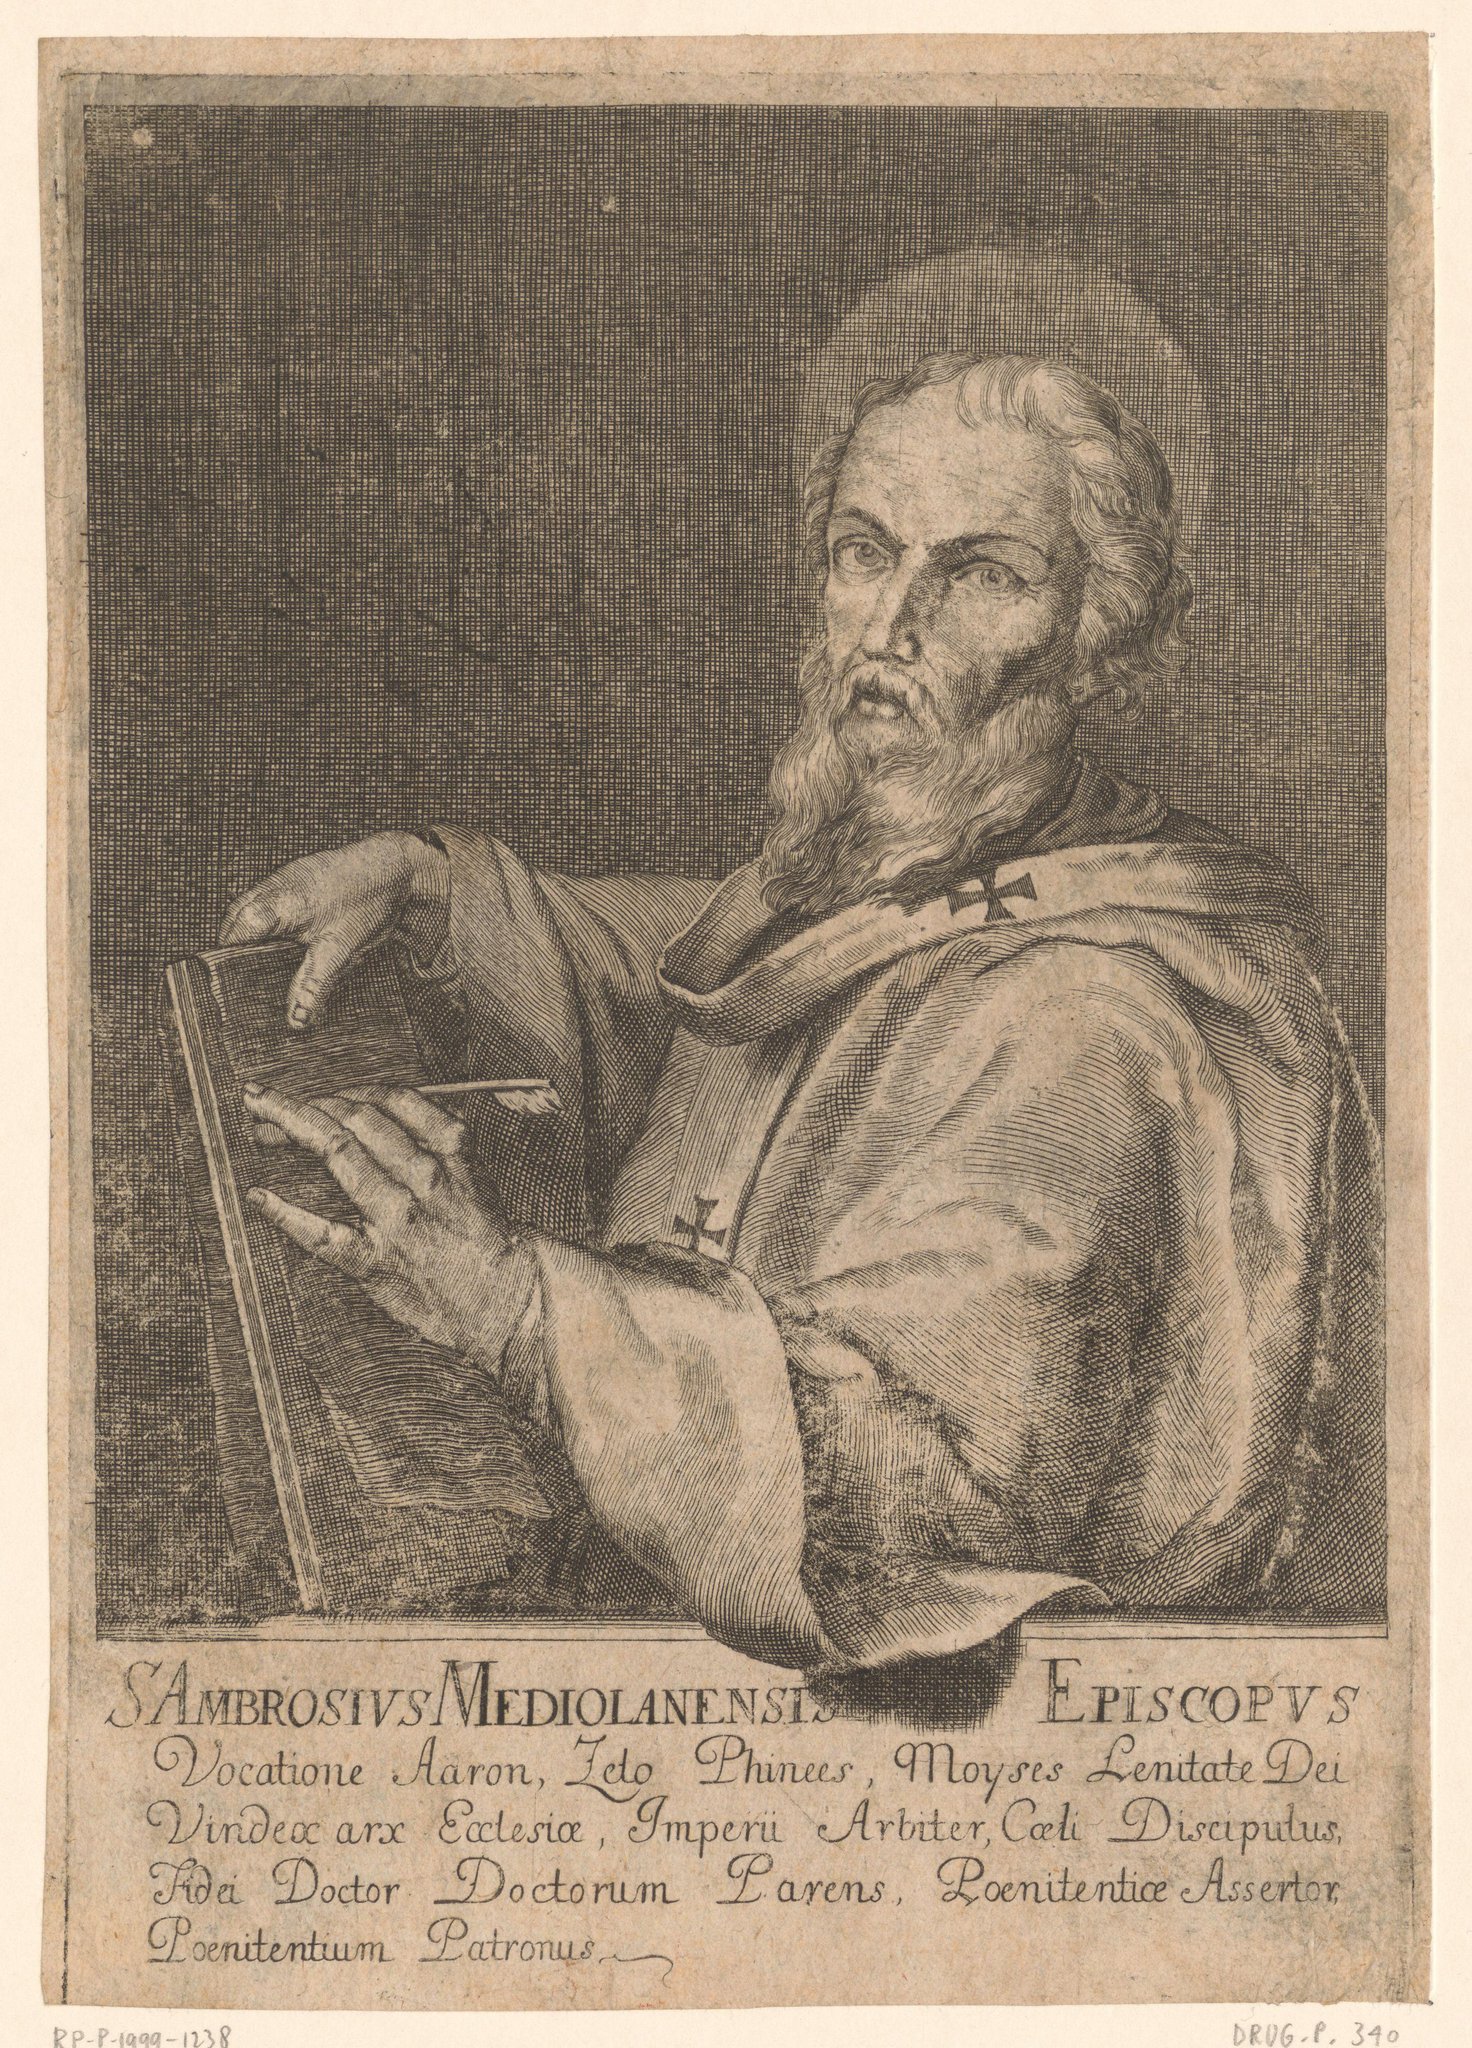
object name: print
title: Portret van kerkvader Ambrosius, bisschop van Milaan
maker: Anonymous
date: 1600-1699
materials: paper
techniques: engraving, etching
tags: theologian, historical persons, book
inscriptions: collector's mark: Lugt 2228